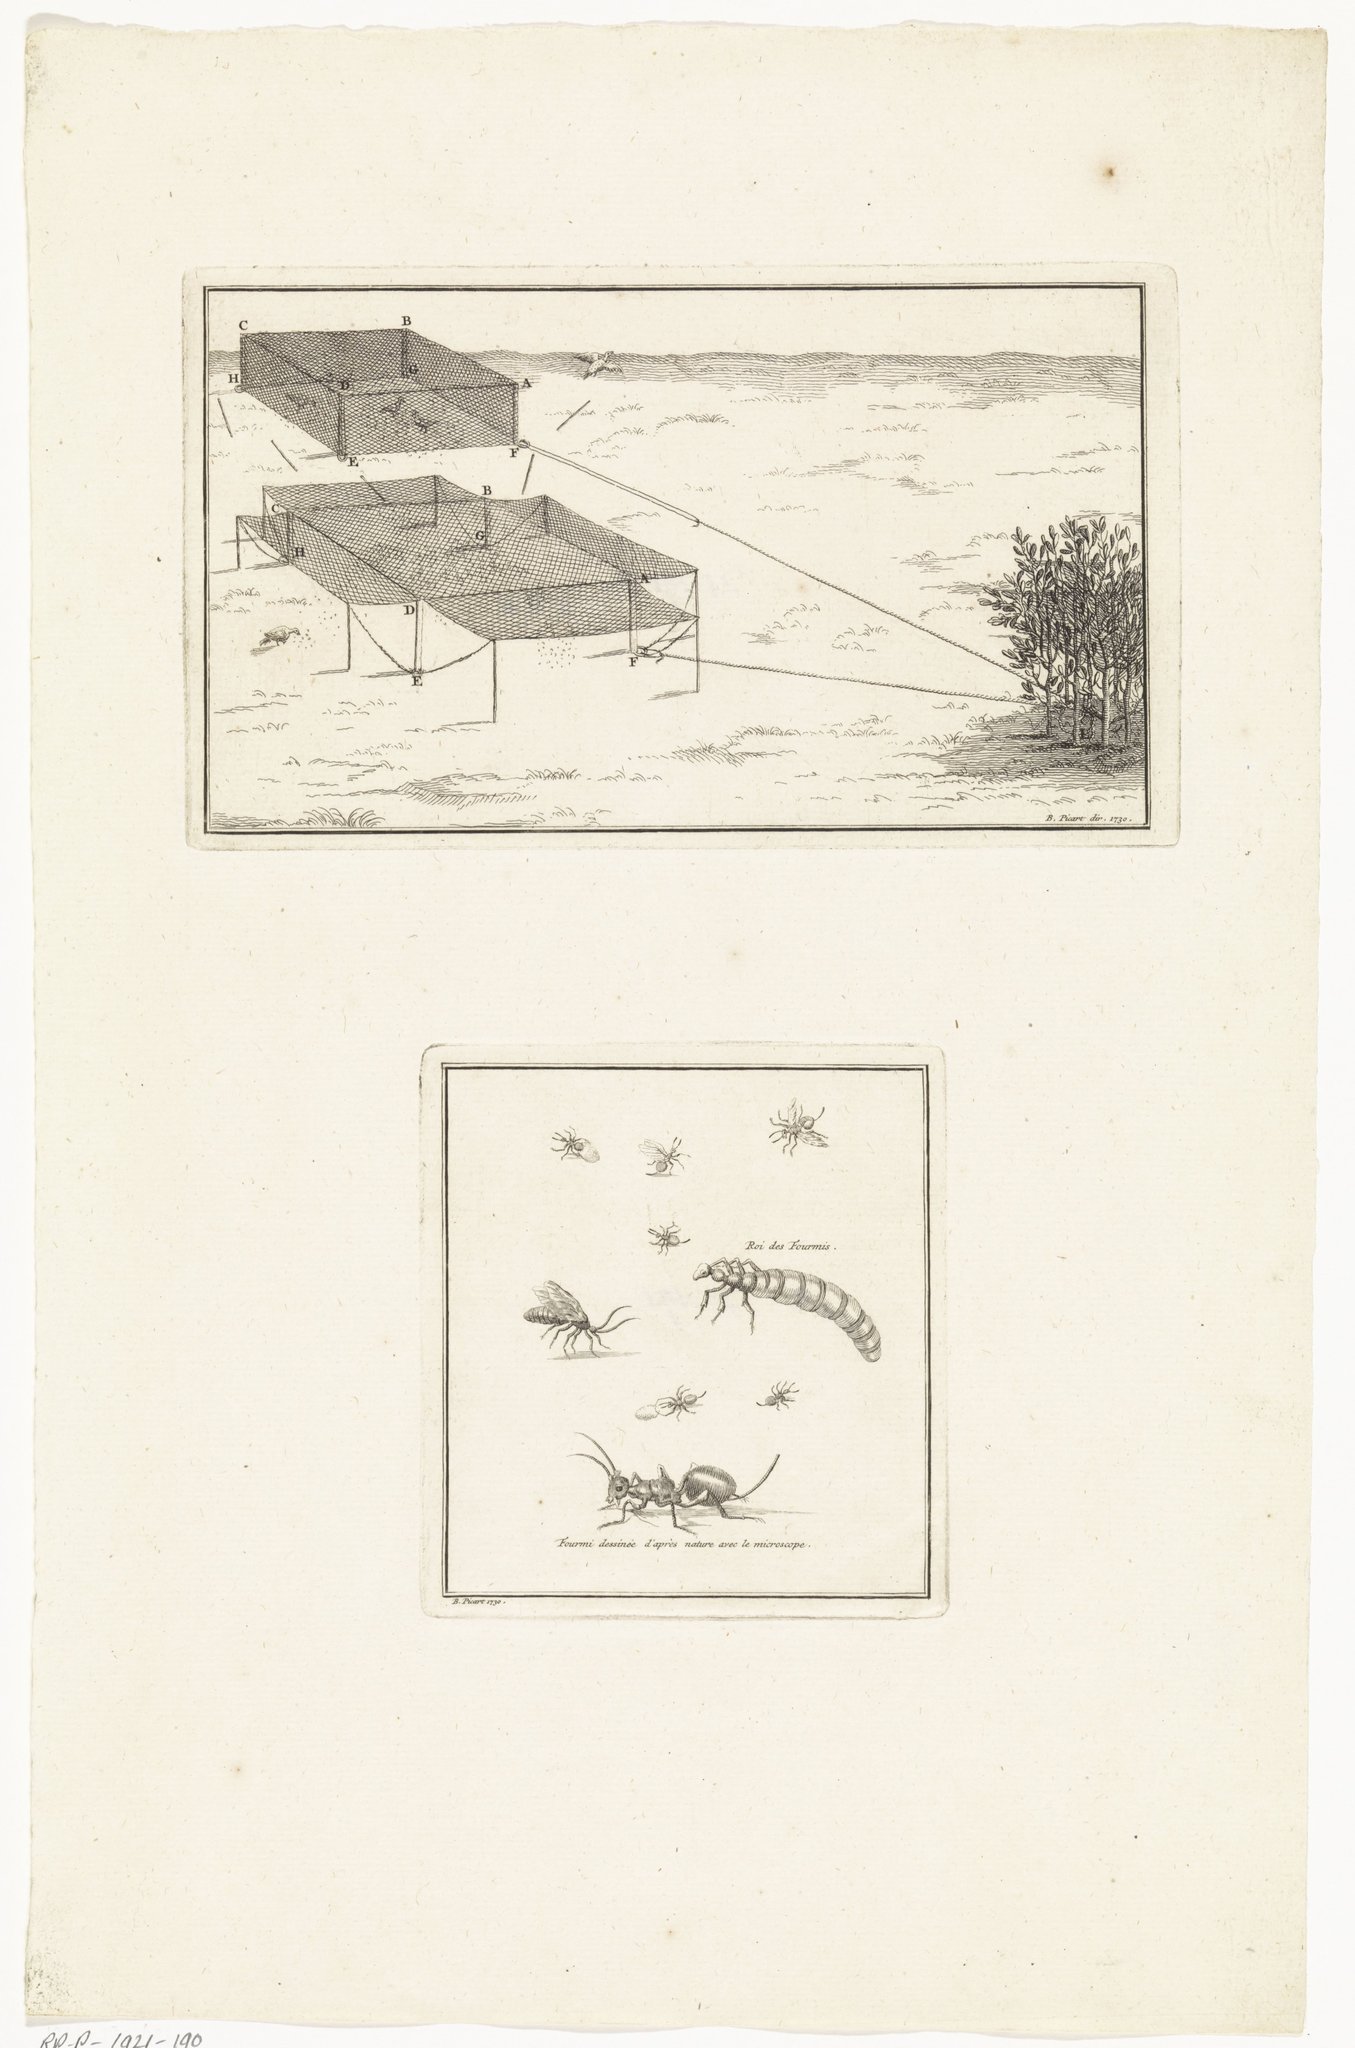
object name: book illustration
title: Netten, mieren en andere insecten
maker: bernard picart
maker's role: draughtsman, print maker, publisher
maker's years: 1673-1733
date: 1730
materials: paper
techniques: etching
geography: amsterdam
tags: insects: ant, catching animals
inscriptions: collector's mark: Lugt 2233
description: Prenten bedoeld voor: Chomel, Noel. Dictionnaire oeconomique, contenant divers moïens d'augmenter son bien, et de conserver sa santé. Amsterdam: Johannes Covens en Cornelis Mortier, 1732.